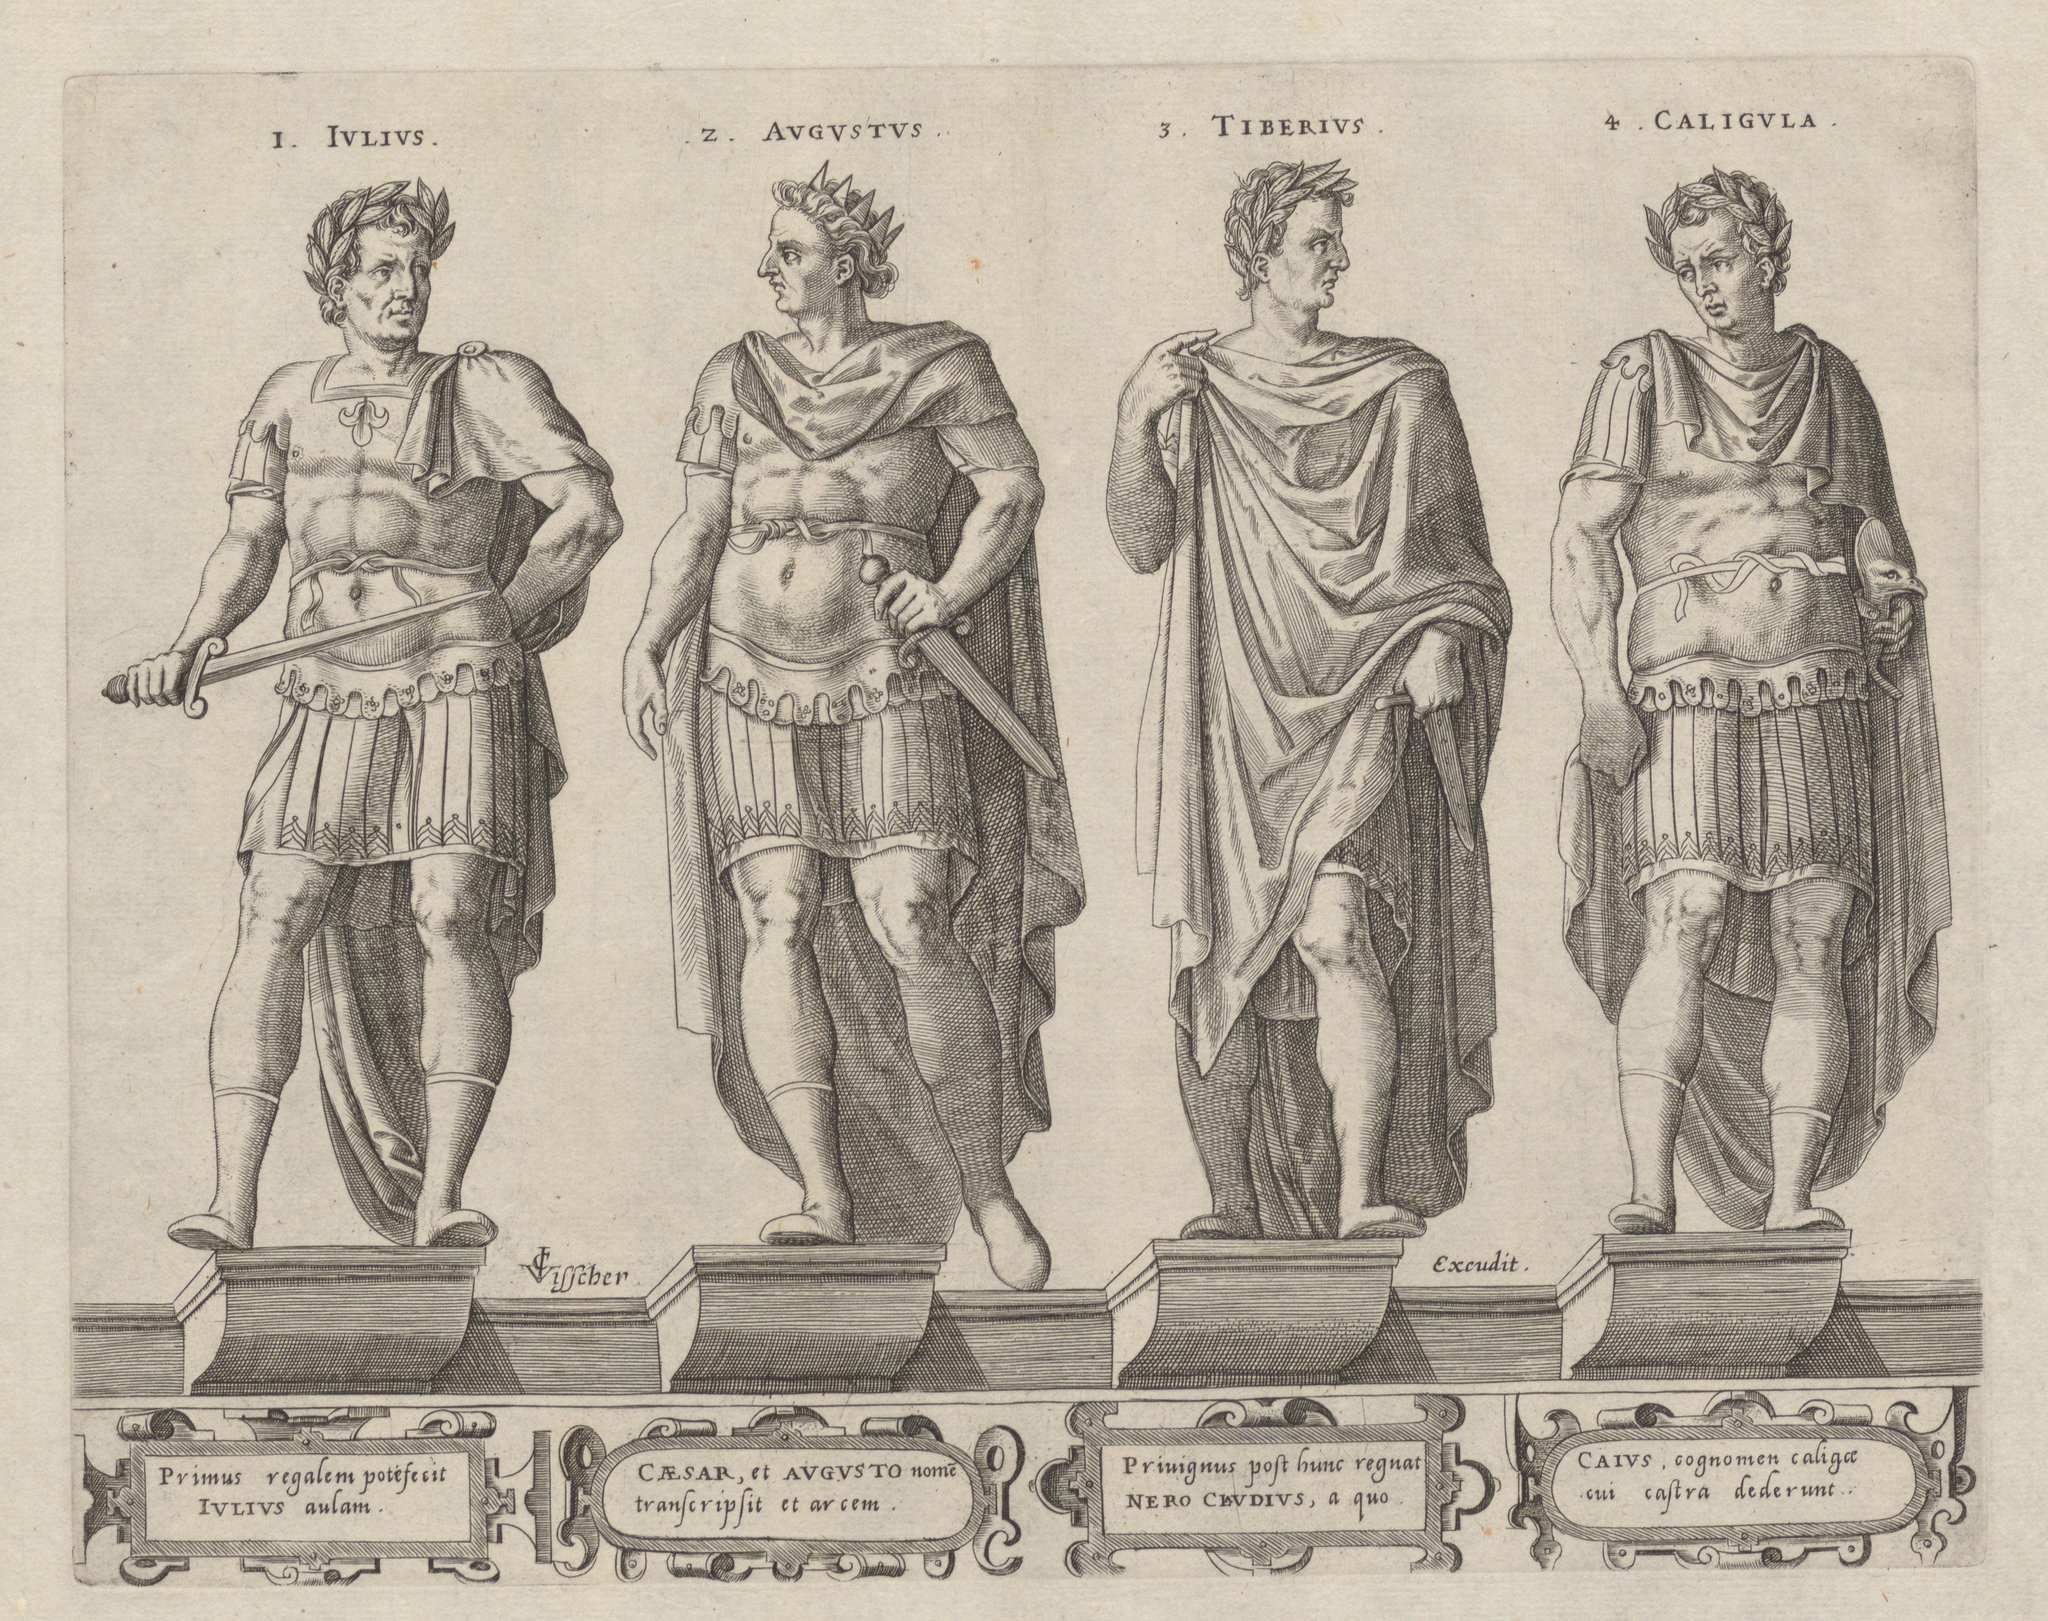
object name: print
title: Portretten van vier Romeinse keizers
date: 1605-1652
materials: paper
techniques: engraving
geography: amsterdam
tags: rome, germany, historical persons, emperor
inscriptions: collector's mark: Lugt 2228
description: Consoles met de eerste vier keizers van het Romeinse Rijk. Afgebeeld ten voeten uit: Julius Caesar, Augustus, keizer van het Romeinse Rijk, Tiberius, keizer van het Romeinse Rijk en Caligula, keizer van het Romeinse Rijk.